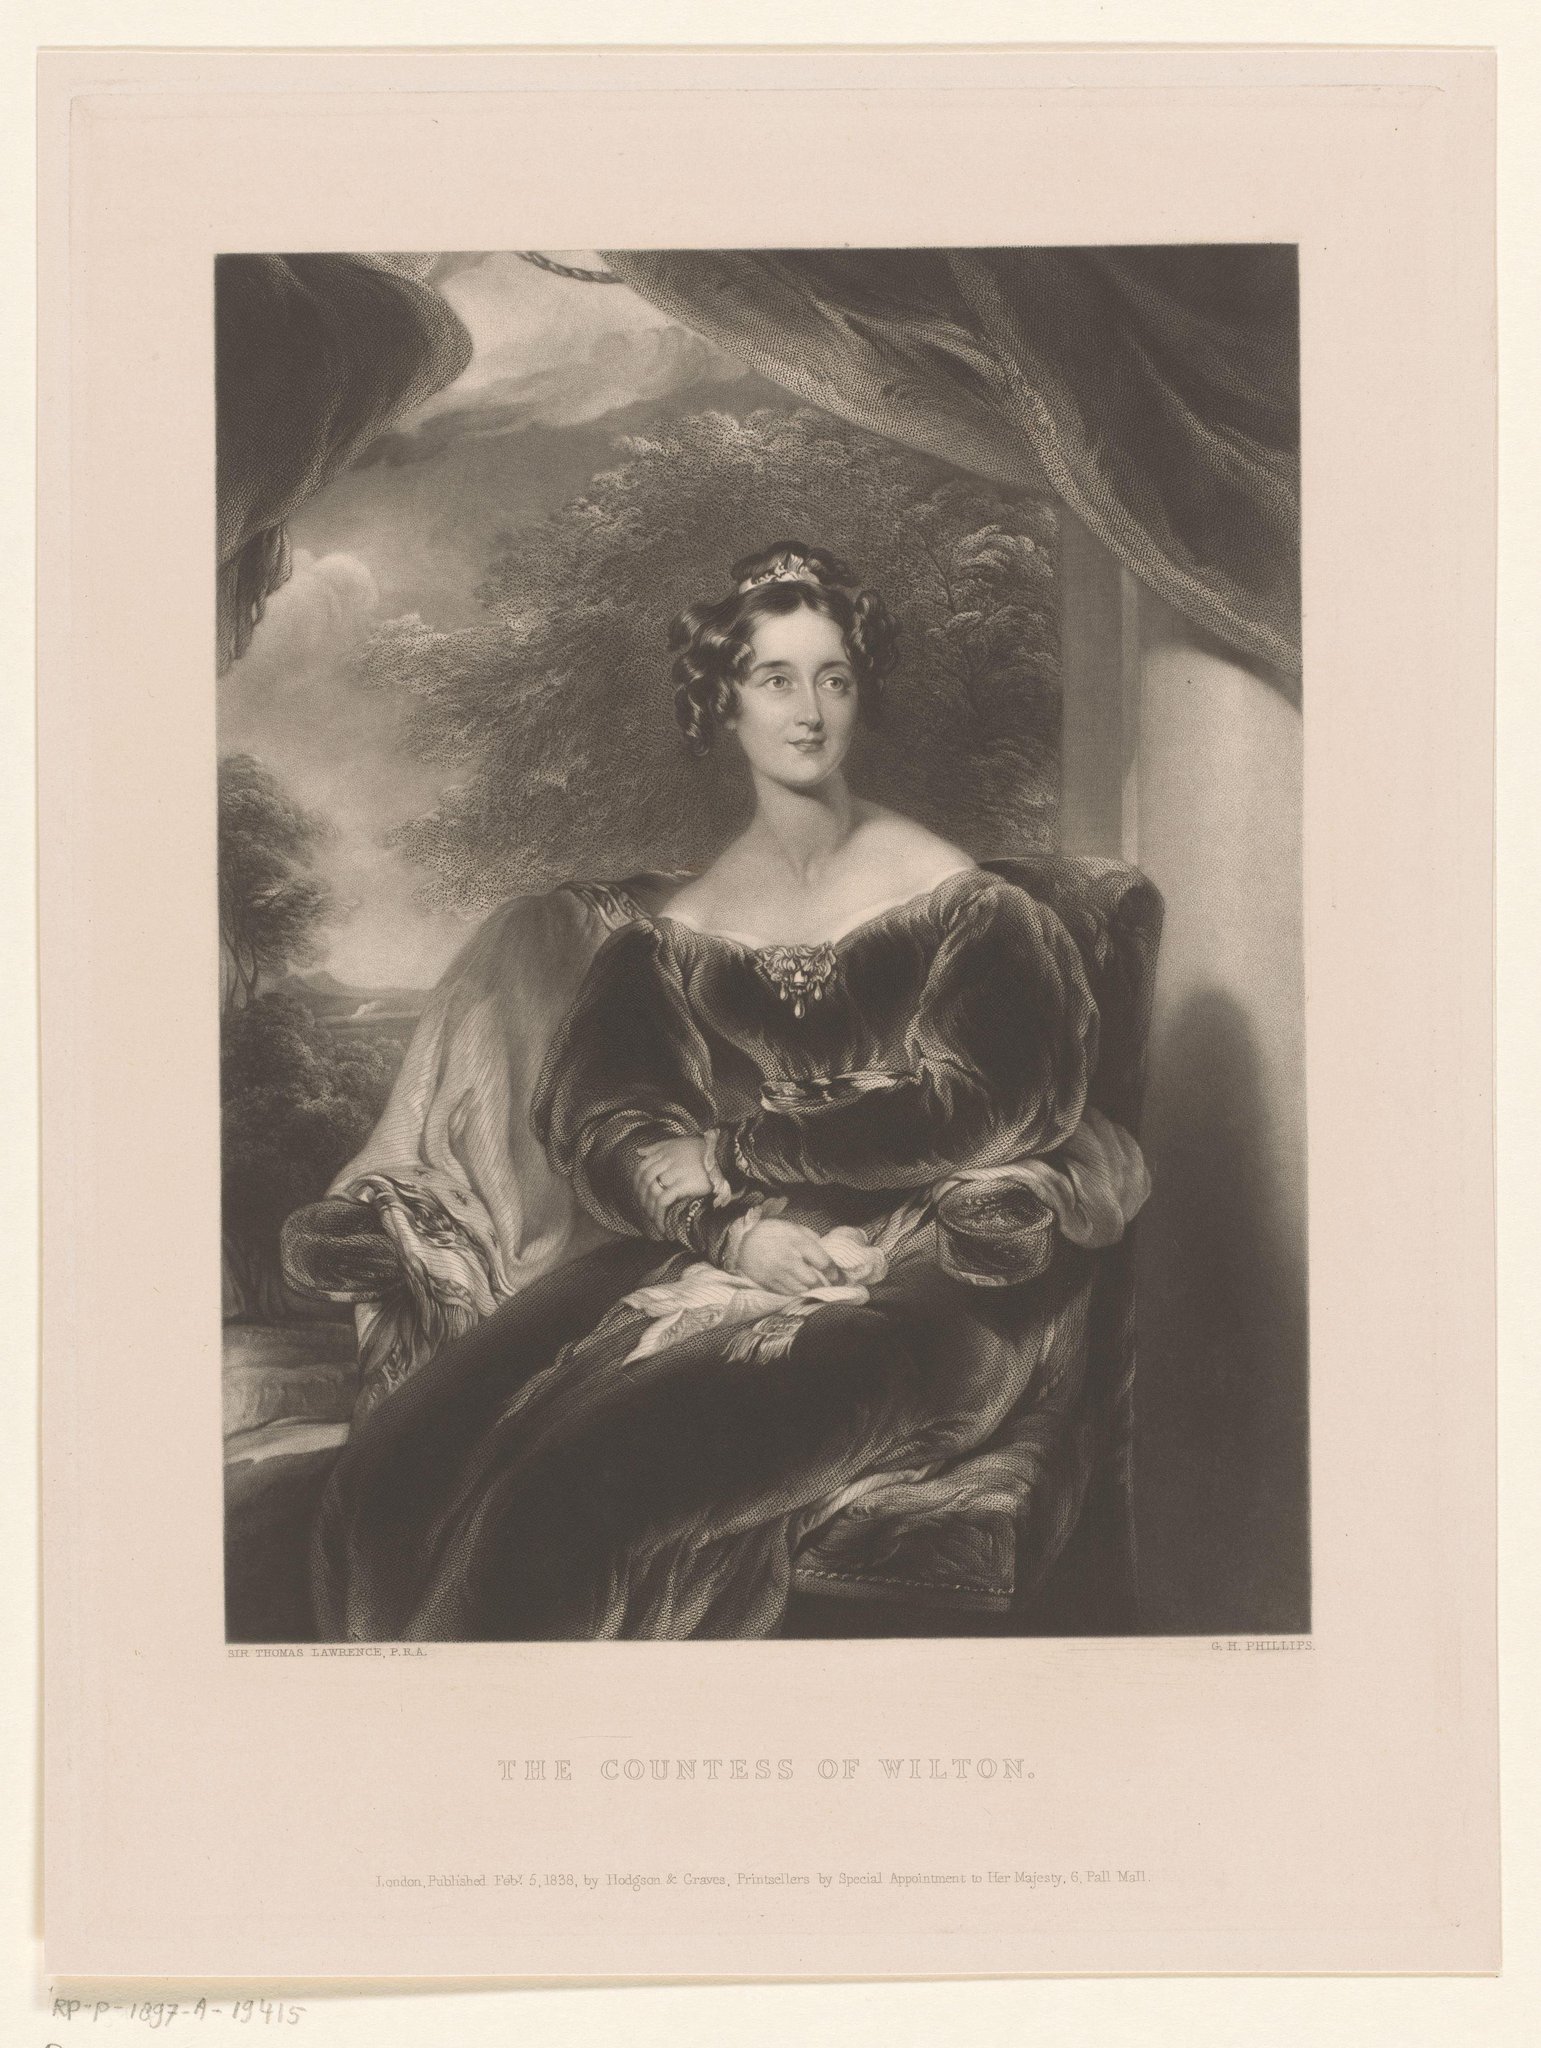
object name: print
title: Portret van Mary Margaret Stanley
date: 1838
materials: paper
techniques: engraving, etching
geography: london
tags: historical persons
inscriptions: collector's mark: Lugt 2228